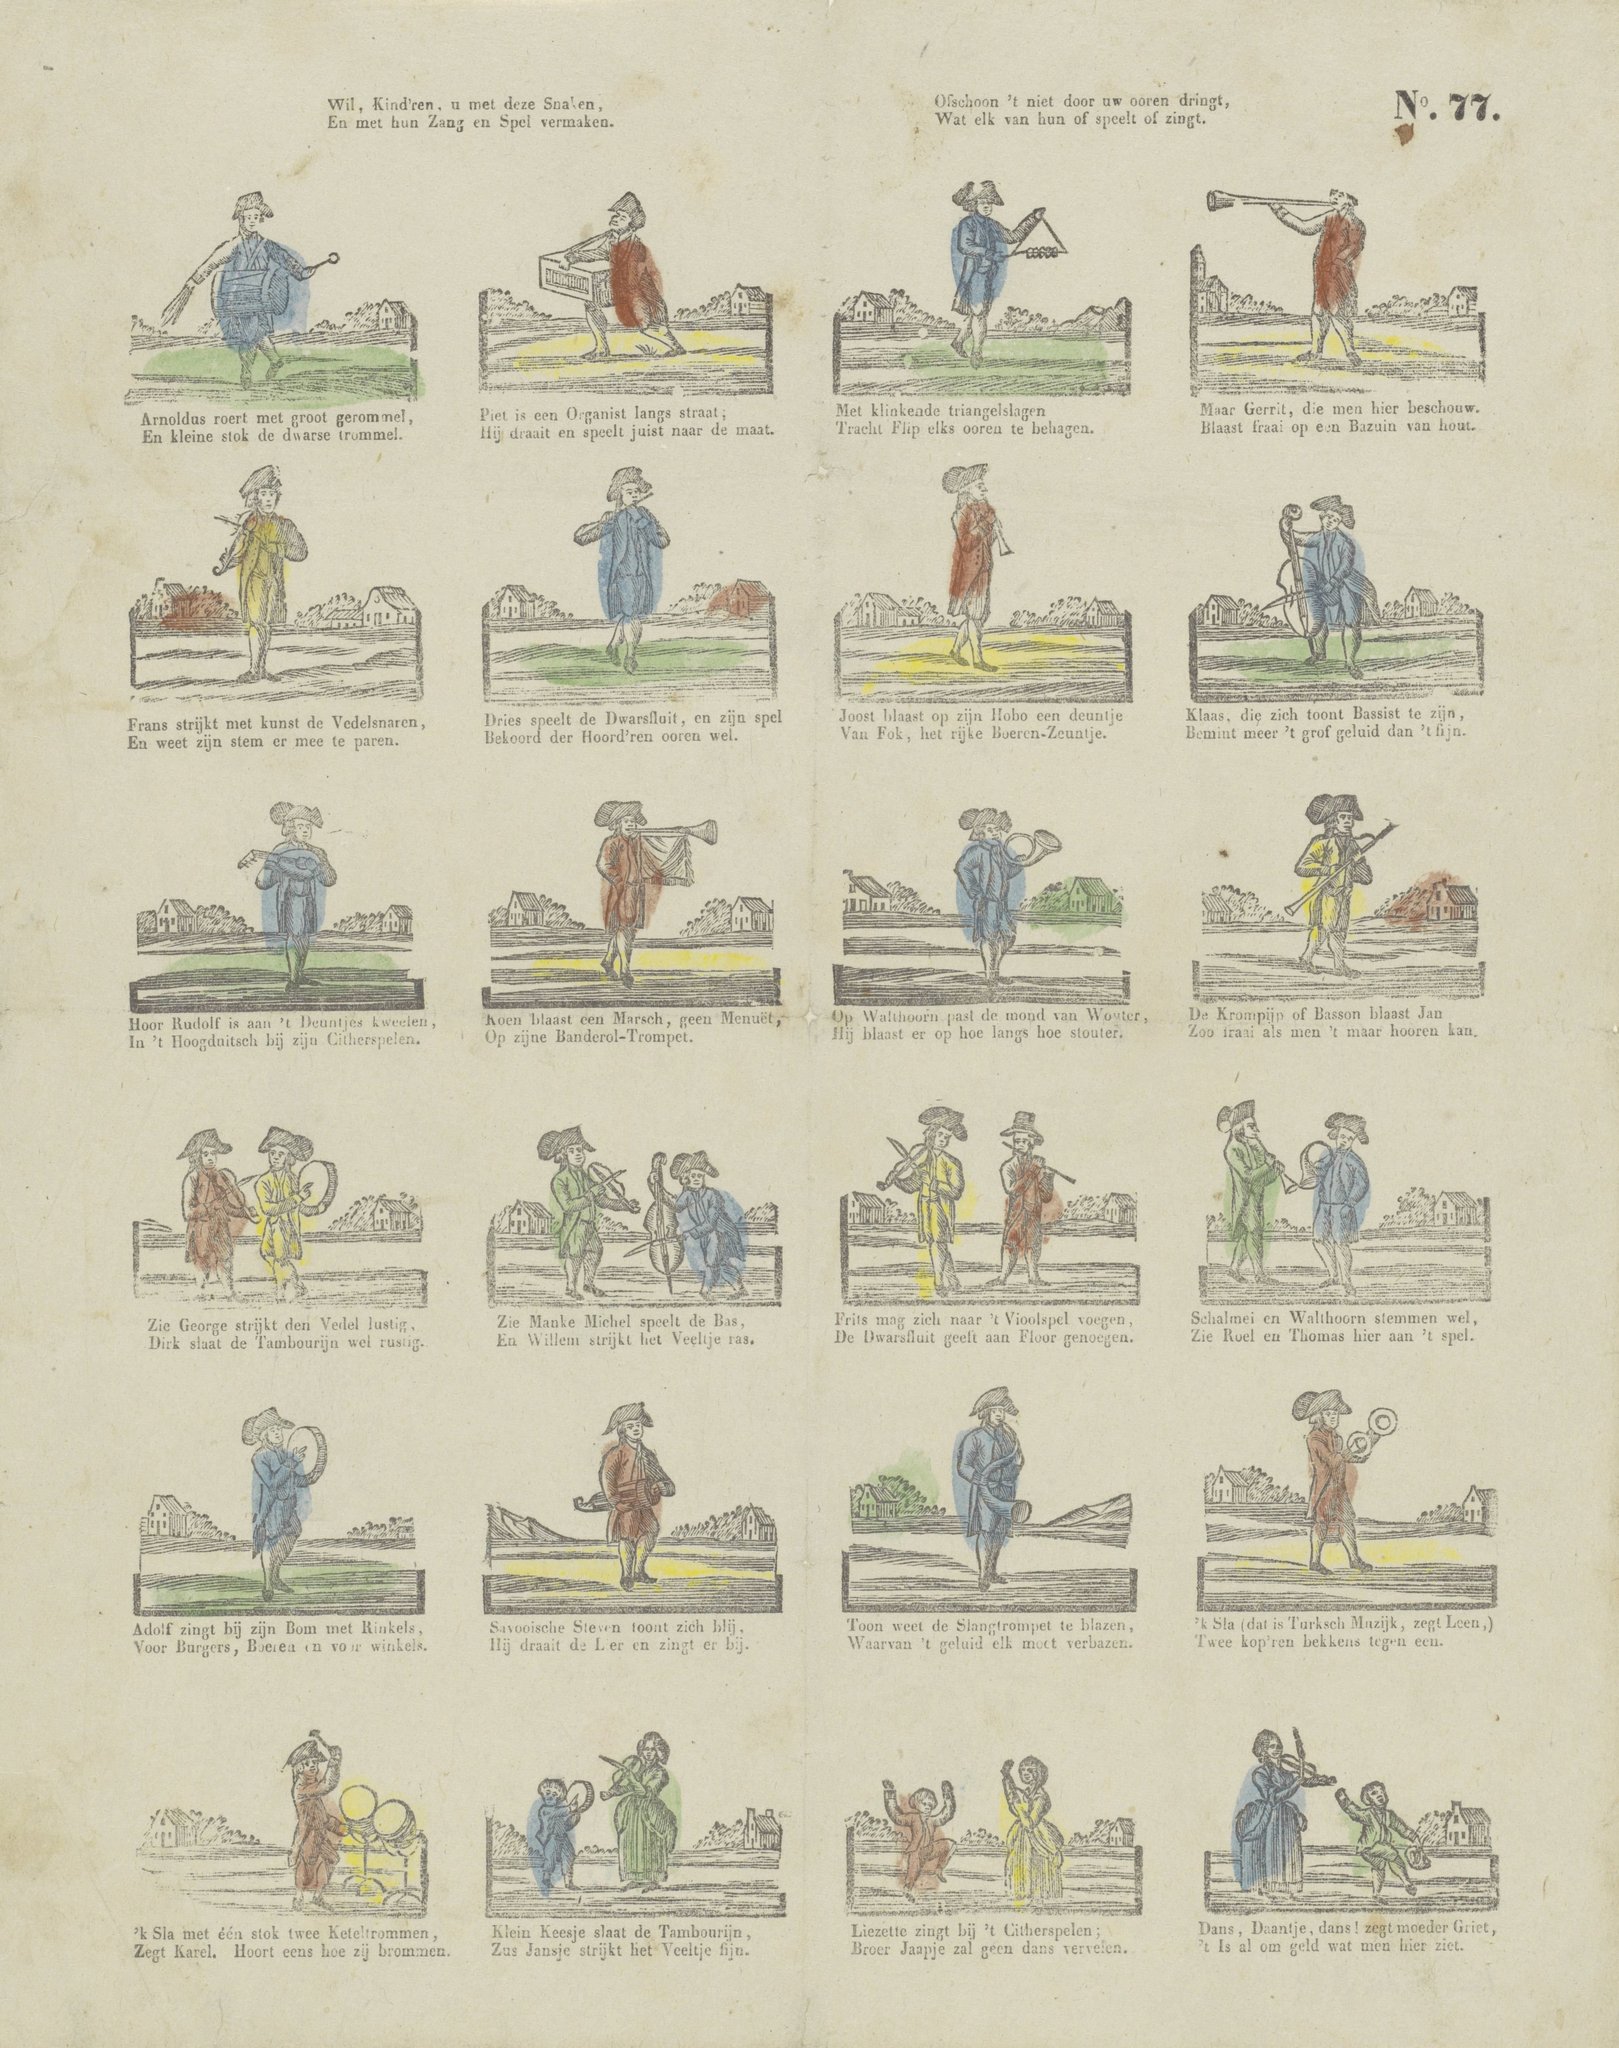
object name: popular print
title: Wil, kind'ren u met deze snaken, / En met hun zang en spel vermaken. / Ofschoon 't niet door uw ooren dringt, / Wat elk van hun of speelt of zingt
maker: Anonymous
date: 1850-1870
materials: paper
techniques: colour, letterpress printing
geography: netherlands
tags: musician at work, making music; musician with instrument, dancing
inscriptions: collector's mark: Lugt 2760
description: Blad met 24 voorstellingen van muzikanten en dansers. Onder elke voorstelling een tweeregelig vers. Genummerd rechtsboven: No. 77.